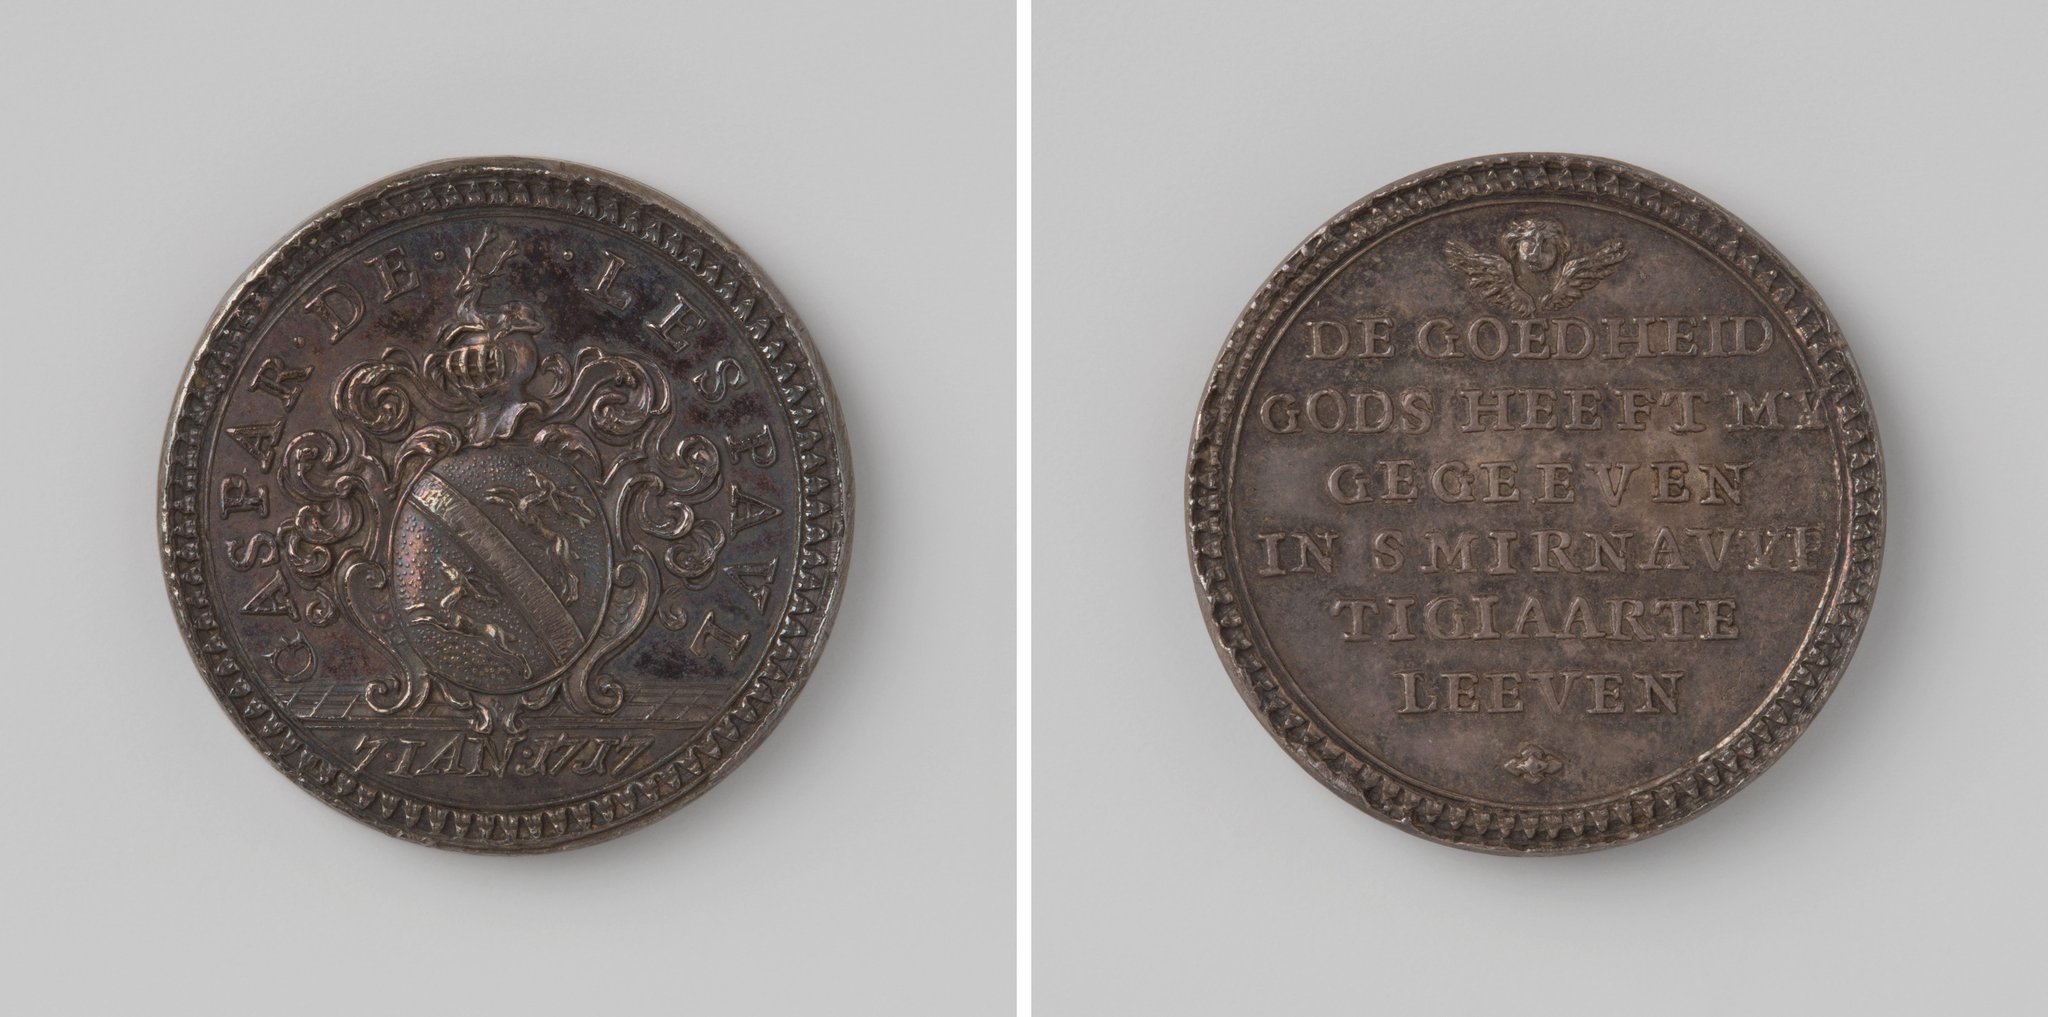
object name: jeton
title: Vijftigjarig verblijf van Gaspar Lespauls te Smyrna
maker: Anonymous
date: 1717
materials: silver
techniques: striking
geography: netherlands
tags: gaspar lespauls, smyrna, izmir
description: Zilveren penning. Voorzijde: gehelmd wapenschild binnen omschrift; afsnede: datum. Keerzijde: opschrift onder gevleugeld engelenkopje